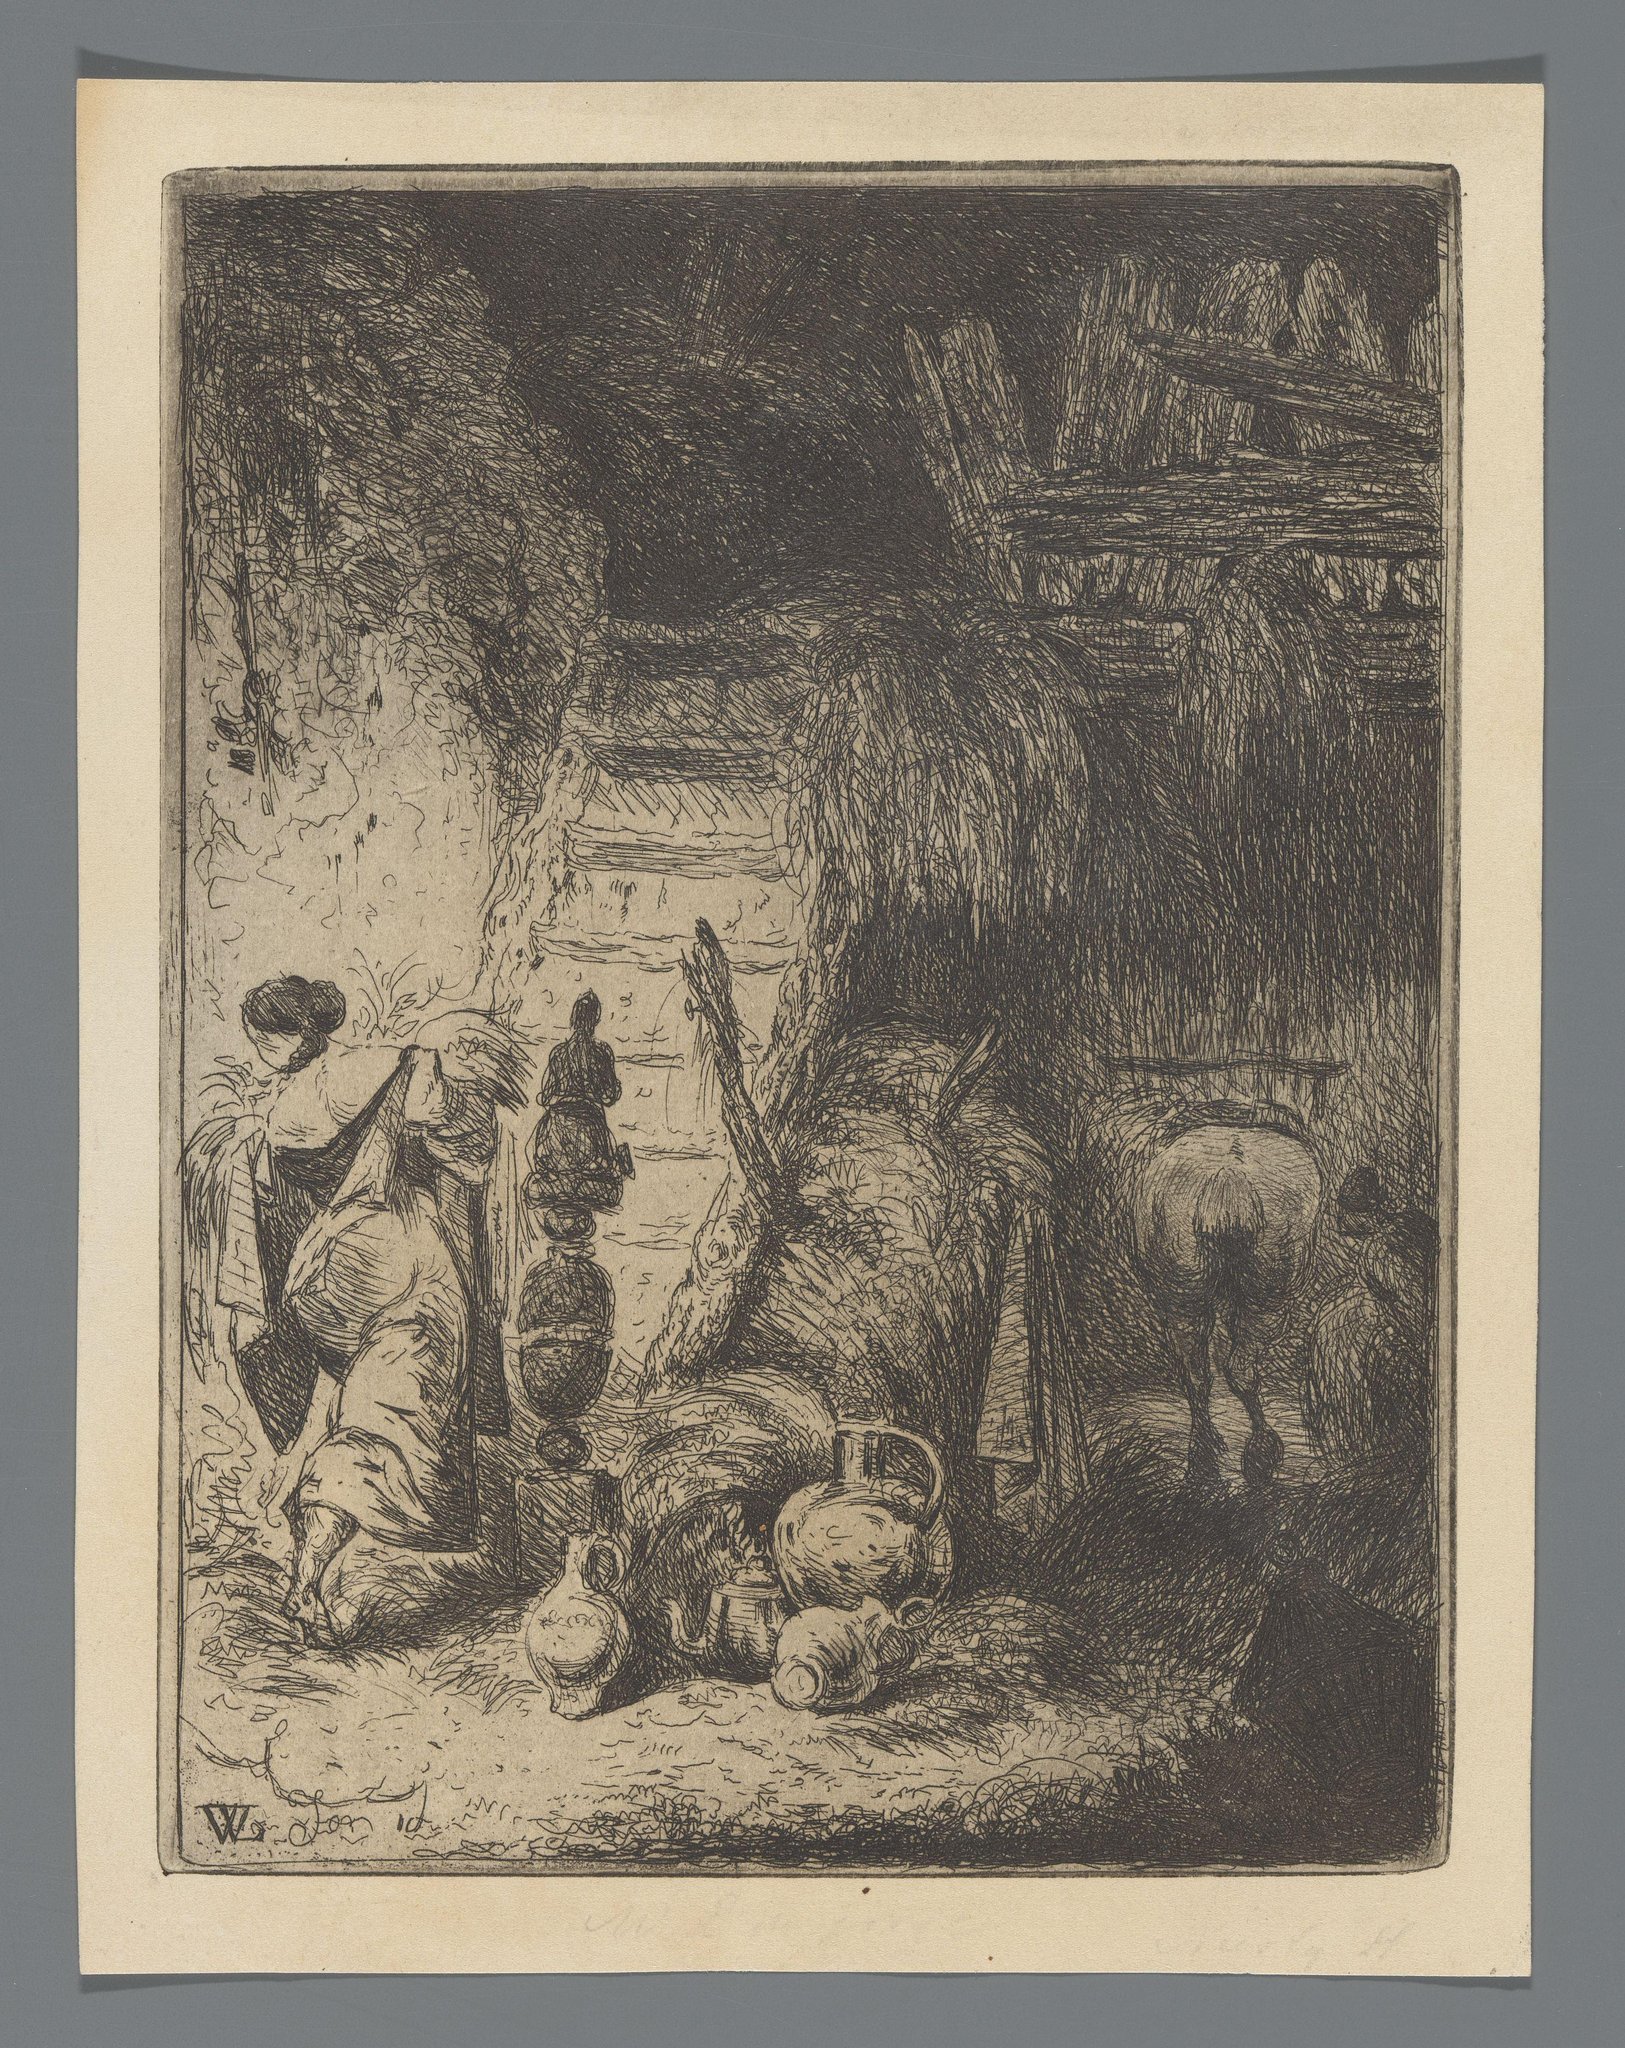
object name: print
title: Boerin in een schuur loopt een trap op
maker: willem linnig (ii)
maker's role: print maker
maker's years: 1842-1890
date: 1852-1889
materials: paper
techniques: etching, intaglio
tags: barn, farmers - aa - female farmer, farmer's wife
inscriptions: collector's mark: Lugt 2228